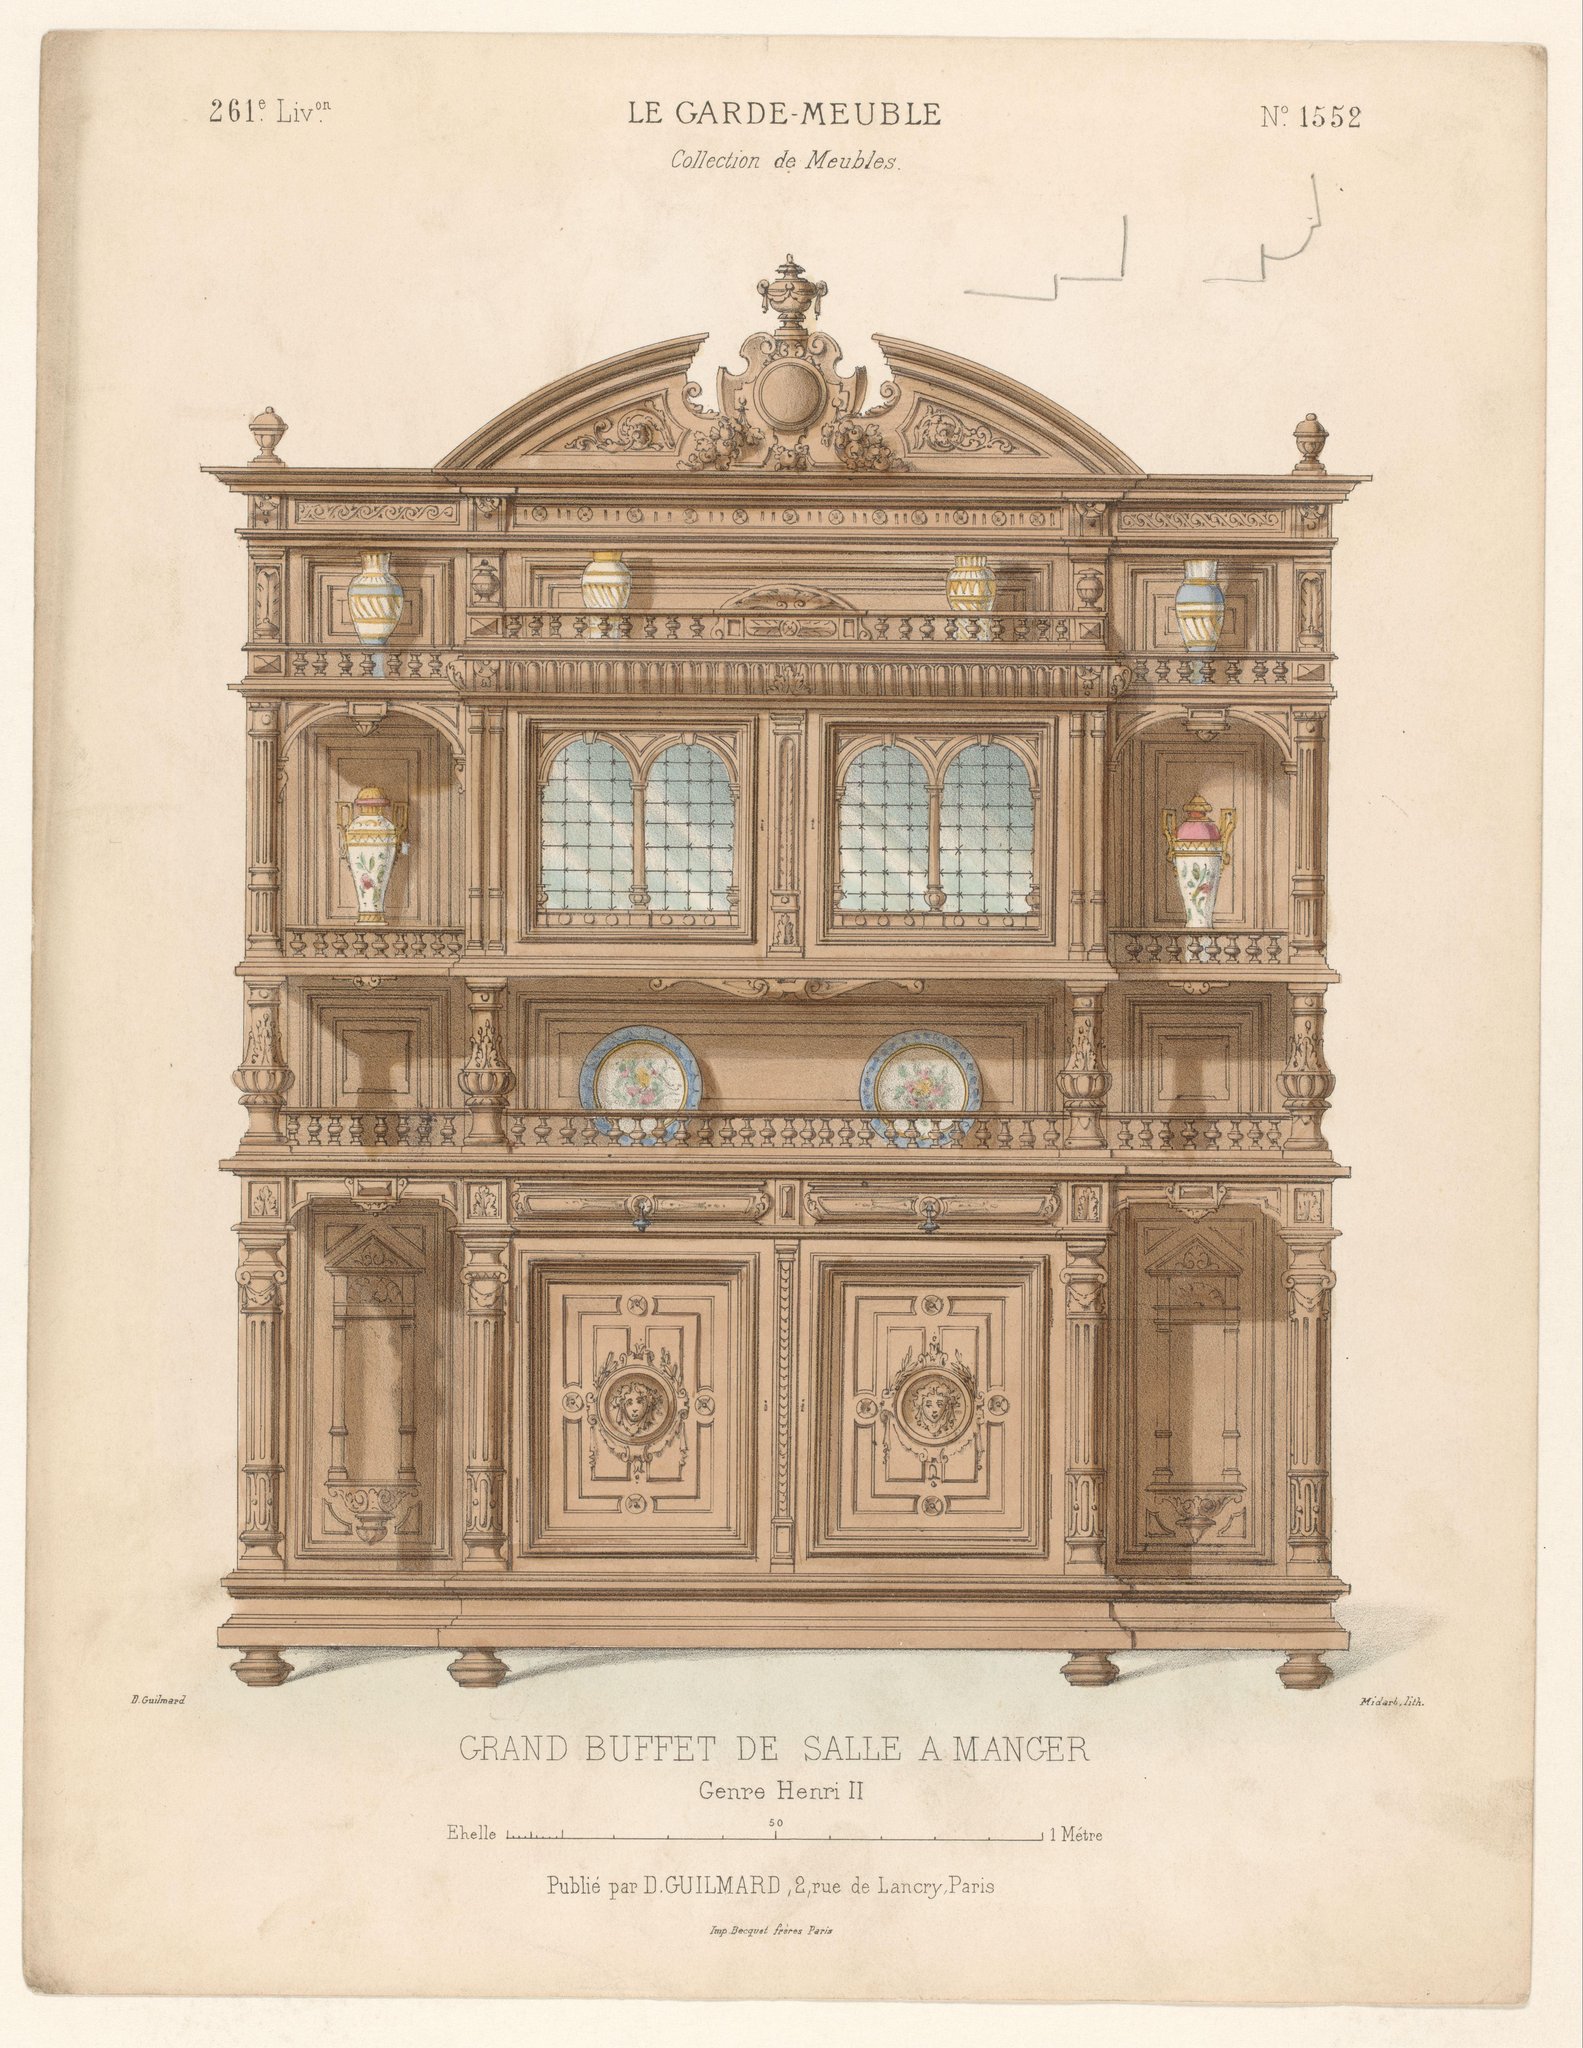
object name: print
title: Le garde-meuble / Collection de Meubles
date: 1845-1862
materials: paper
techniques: hand coloring, lithograph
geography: paris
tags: furniture for storage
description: Ieder Livraison in de serie Le Garde-Meuble bevat negen platen: drie 'sièges' (zitmeubels), drie 'meubles' (diverse meubels zoals tafels en kasten) en drie 'tentures' (gordijnen en draperieën).